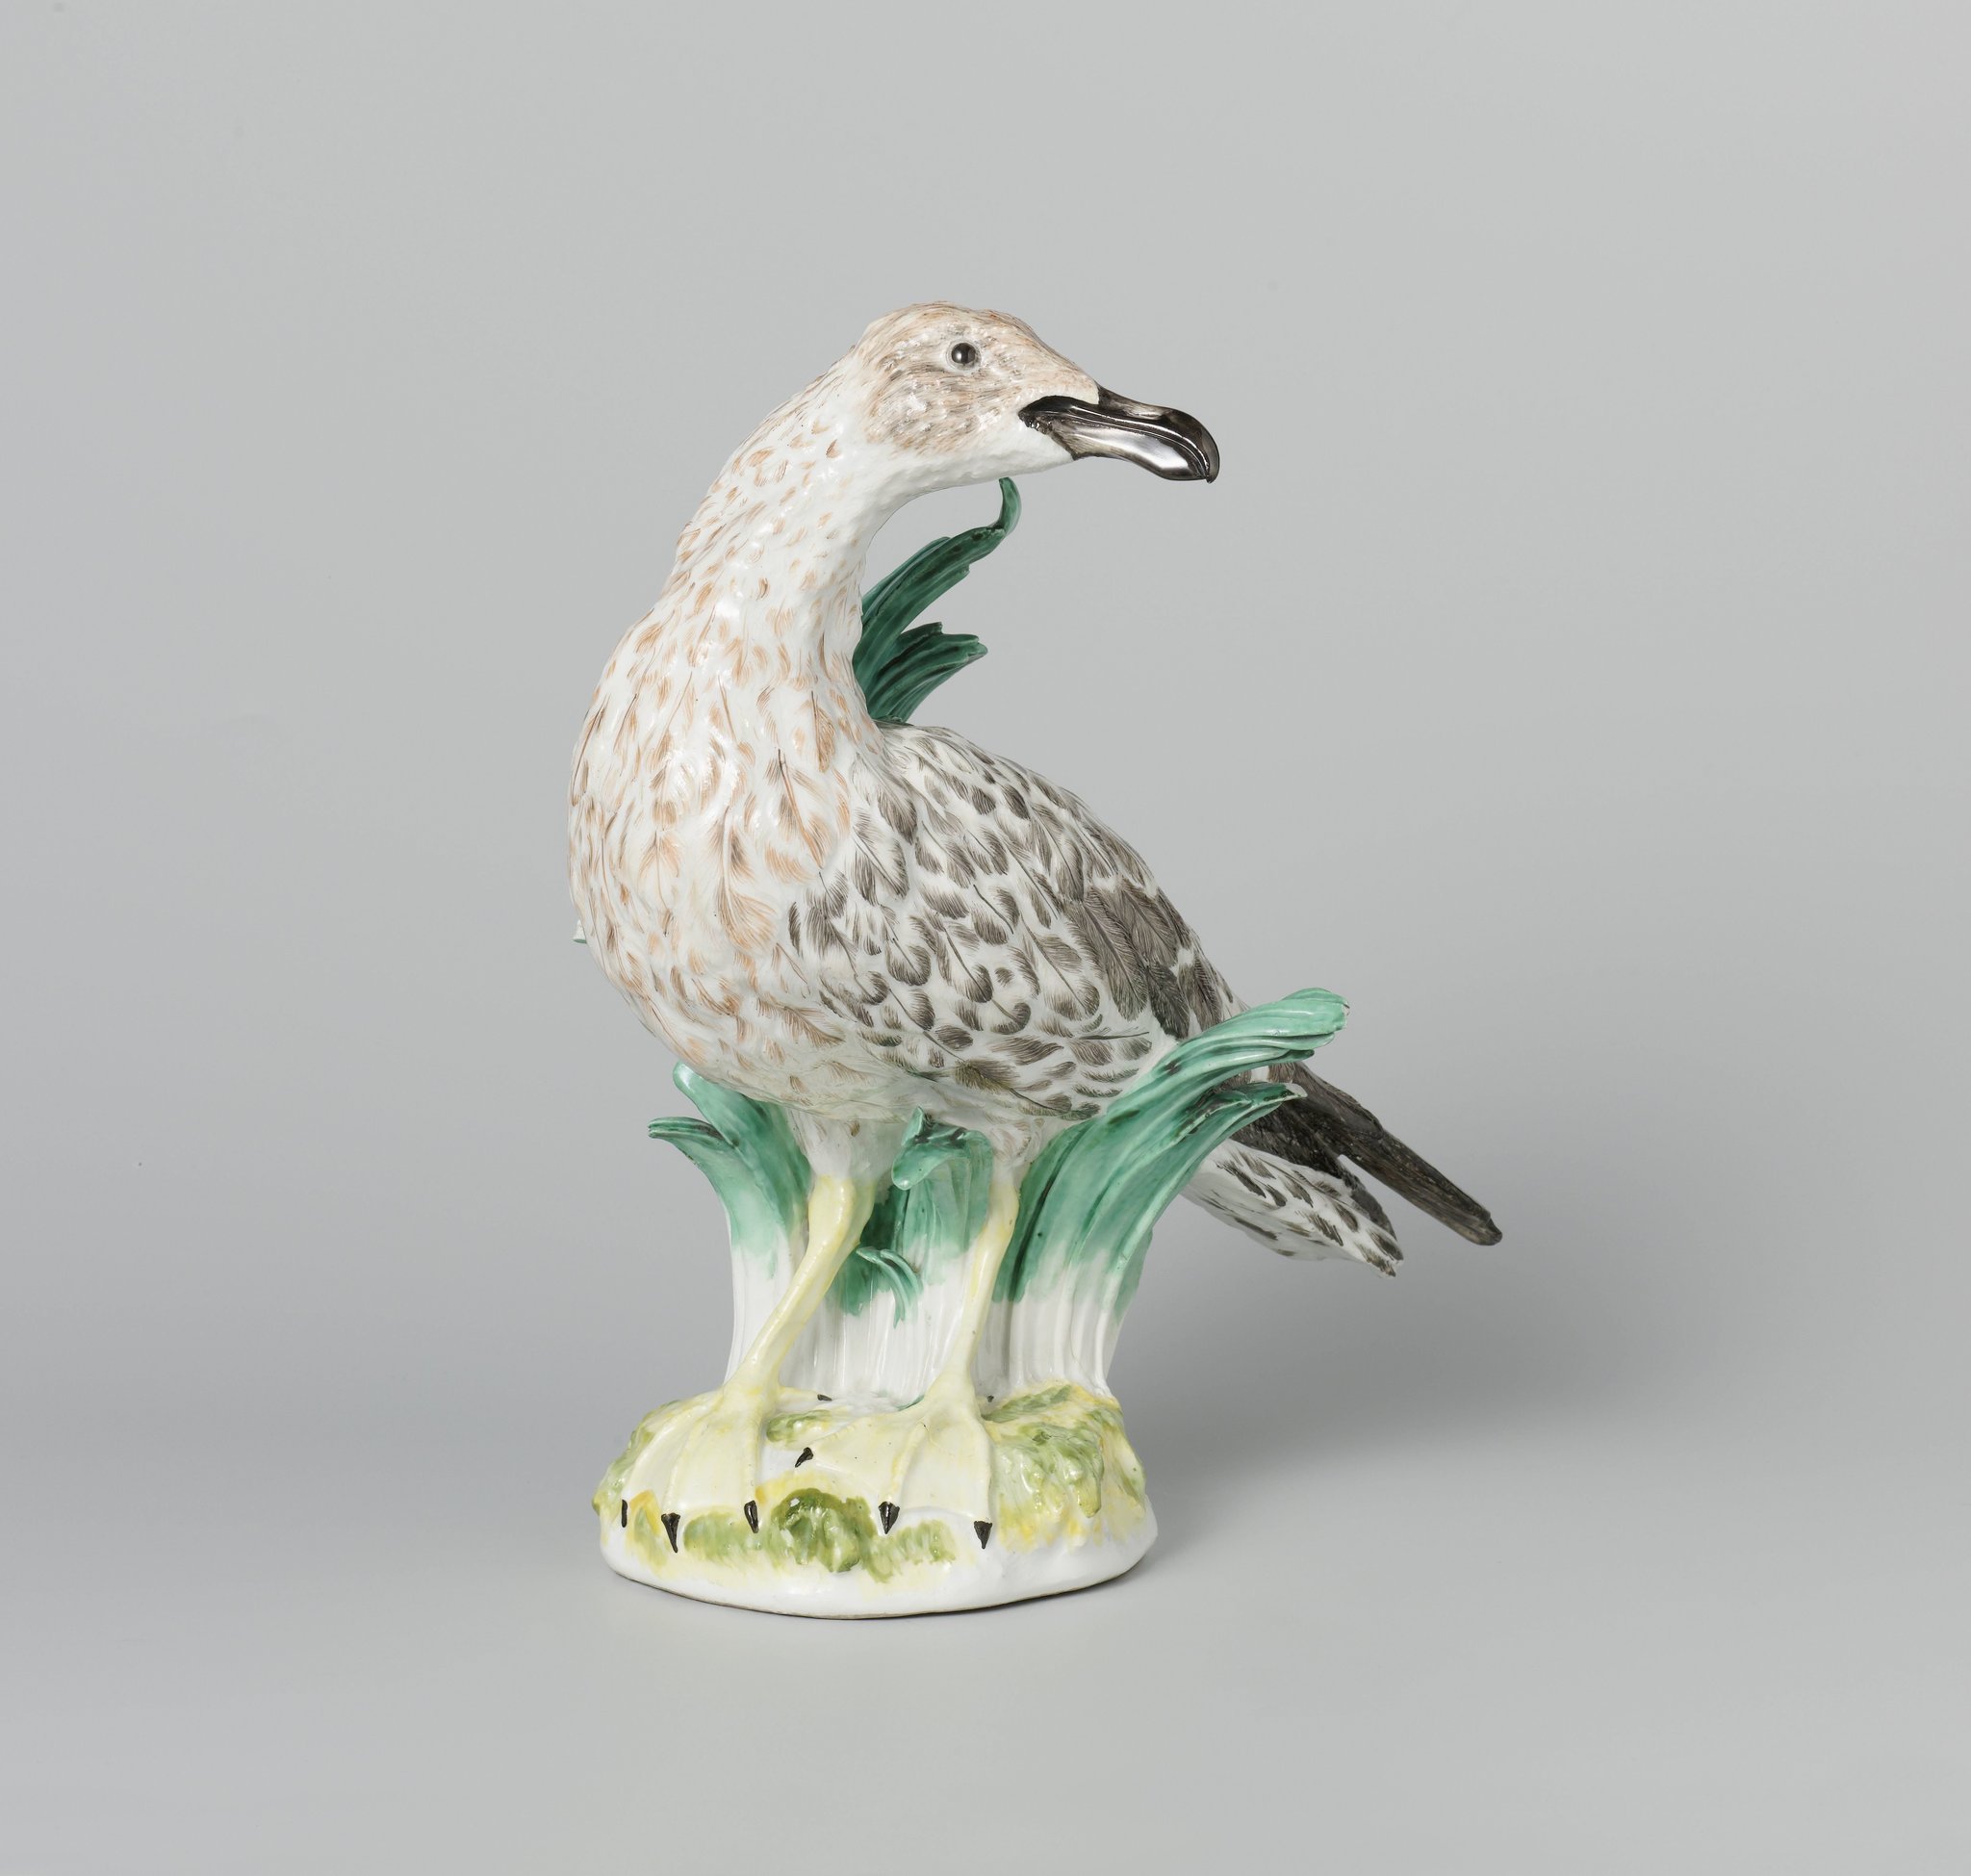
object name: figure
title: Meeuw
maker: johann joachim kändler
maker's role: designer, sculptor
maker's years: 1706-1775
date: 1750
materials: porcelain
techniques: painted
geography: meissen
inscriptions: factory mark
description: Two seagulls. Porcelain. Meissen, c. 1750, the model by Johann Joachim Kändler.